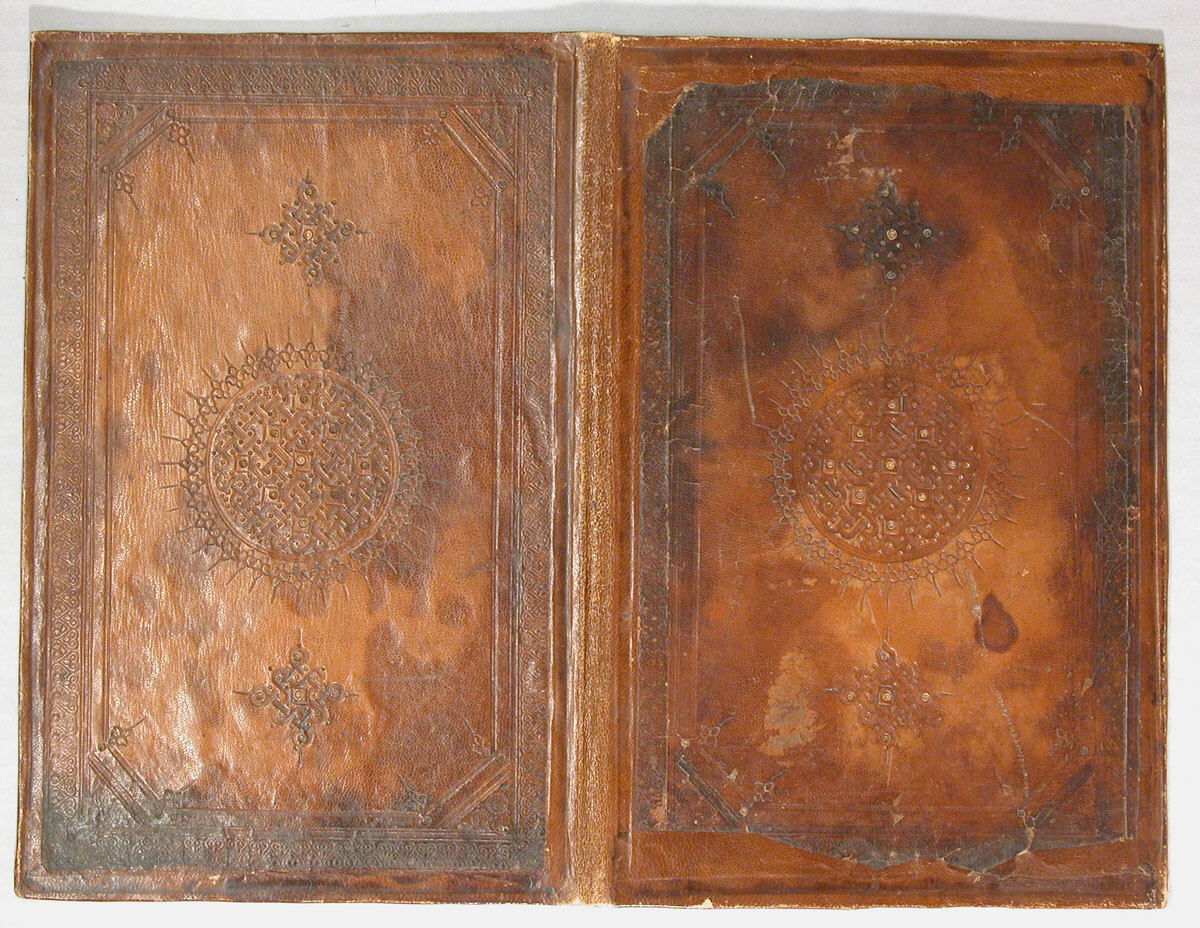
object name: bookbinding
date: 1301-1400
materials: leather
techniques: gilding, stamping, tooling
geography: egypt